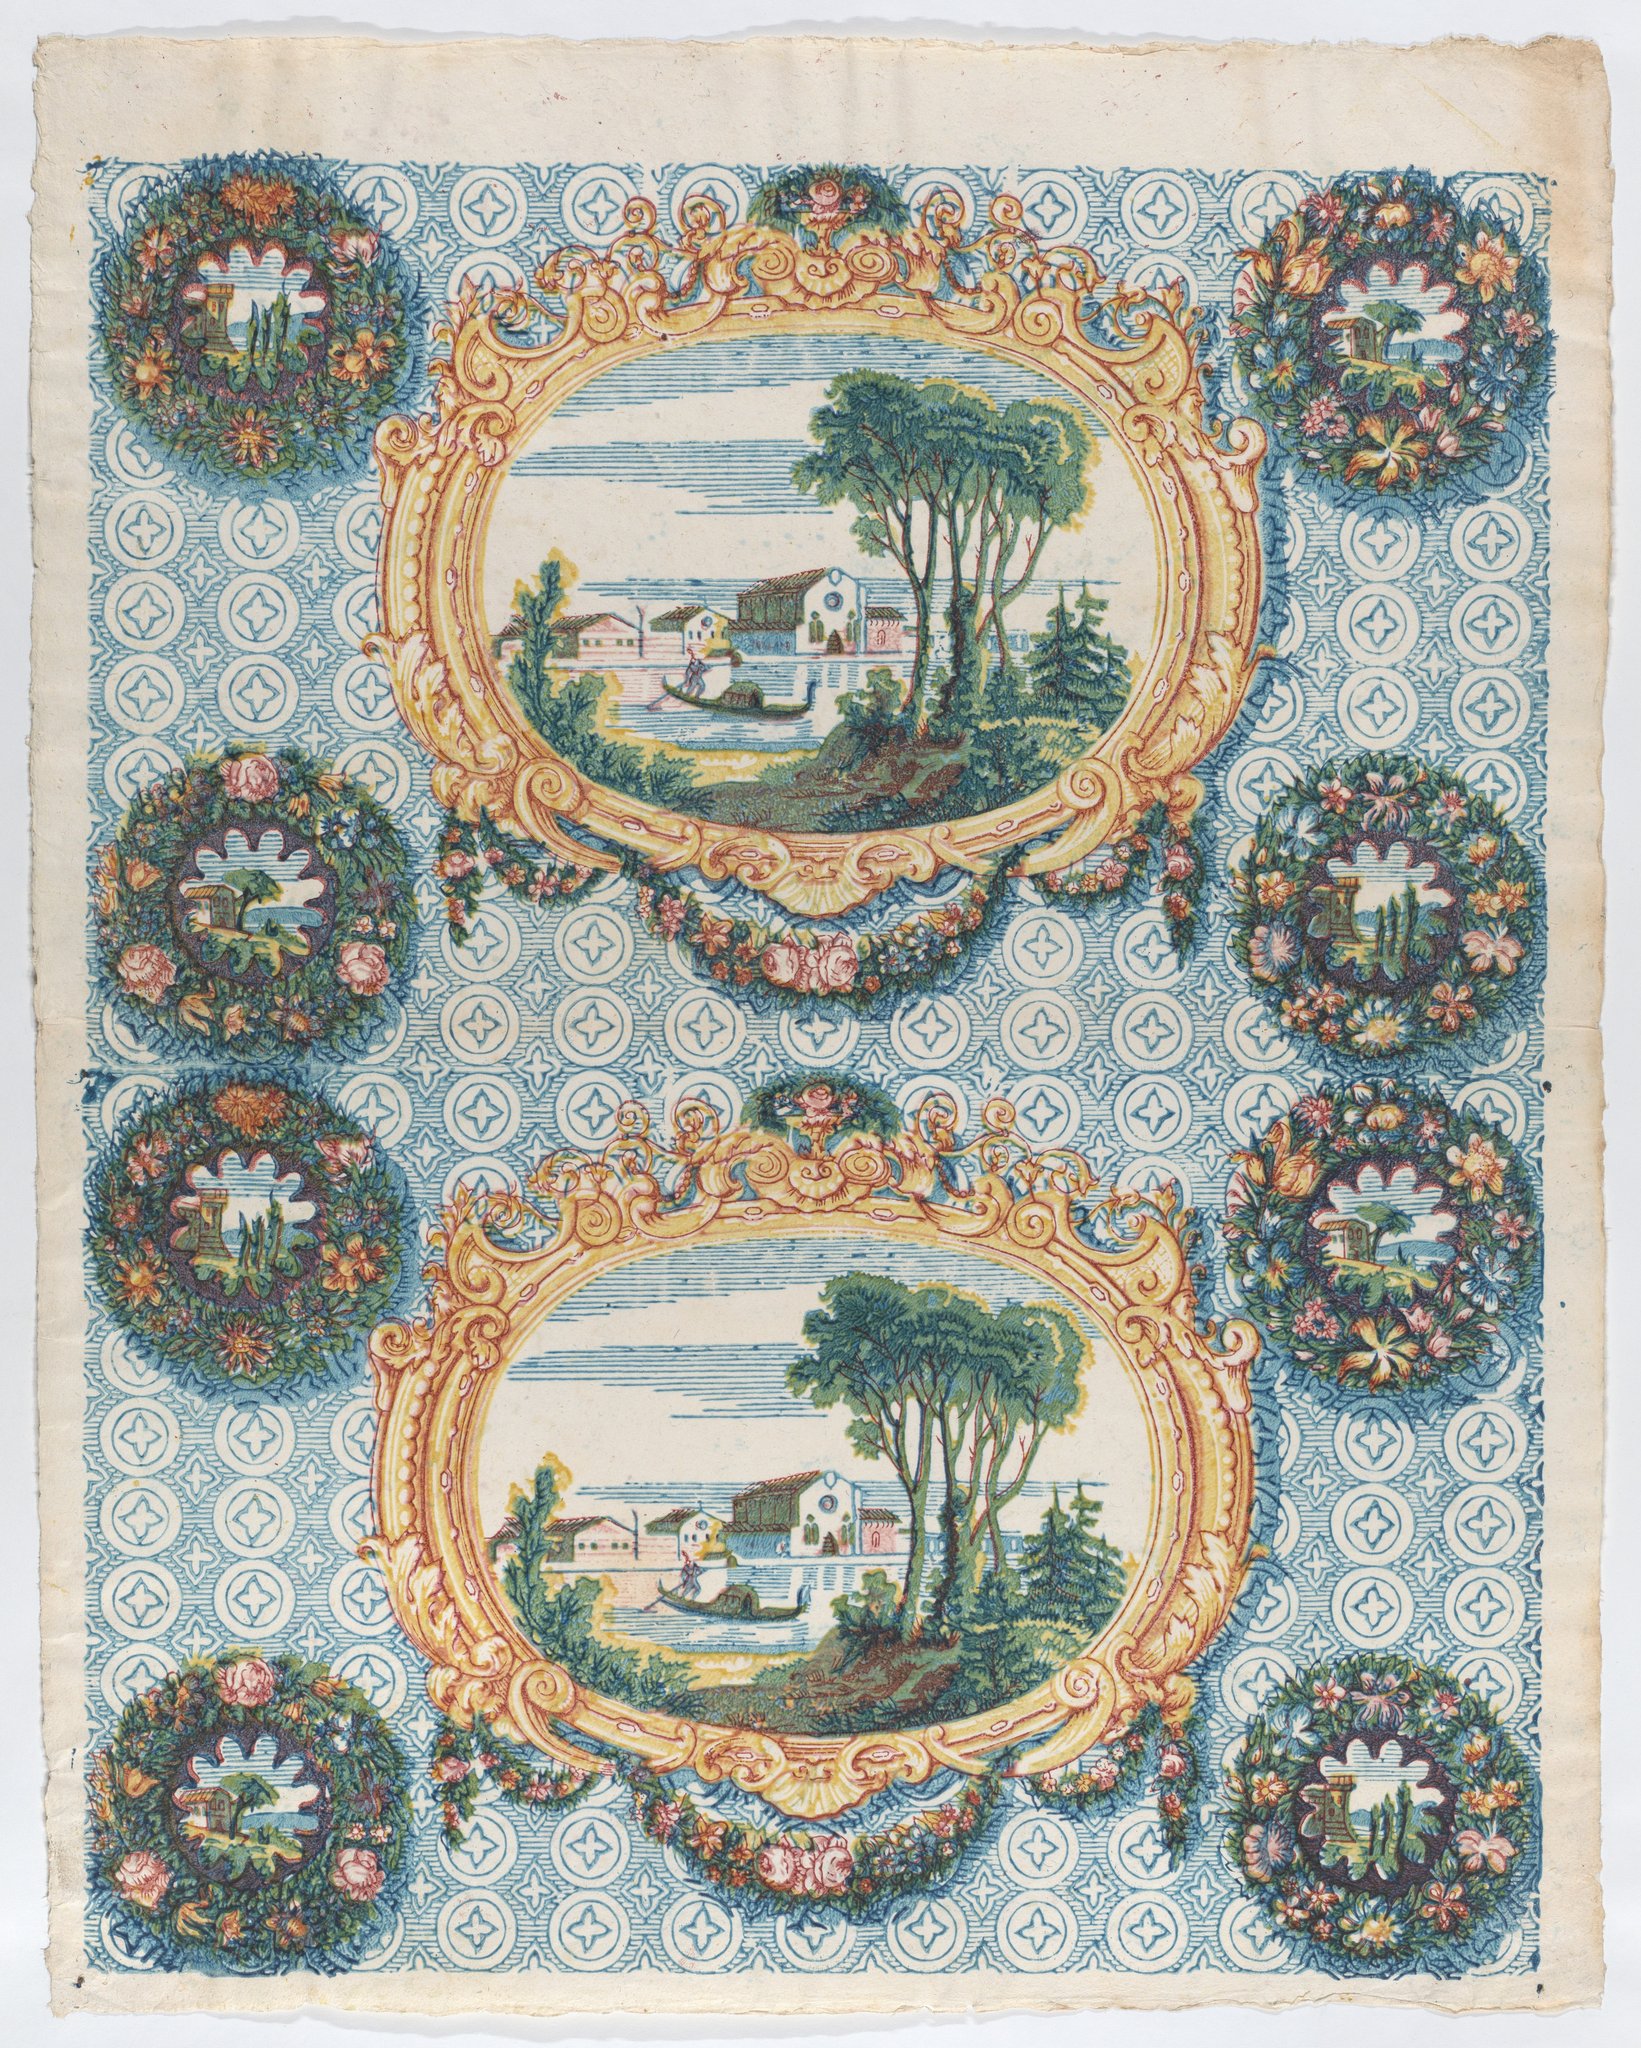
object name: print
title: Sheet with two borders with landscapes within frames and wreaths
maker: Anonymous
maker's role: artist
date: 1767-1866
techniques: relief print